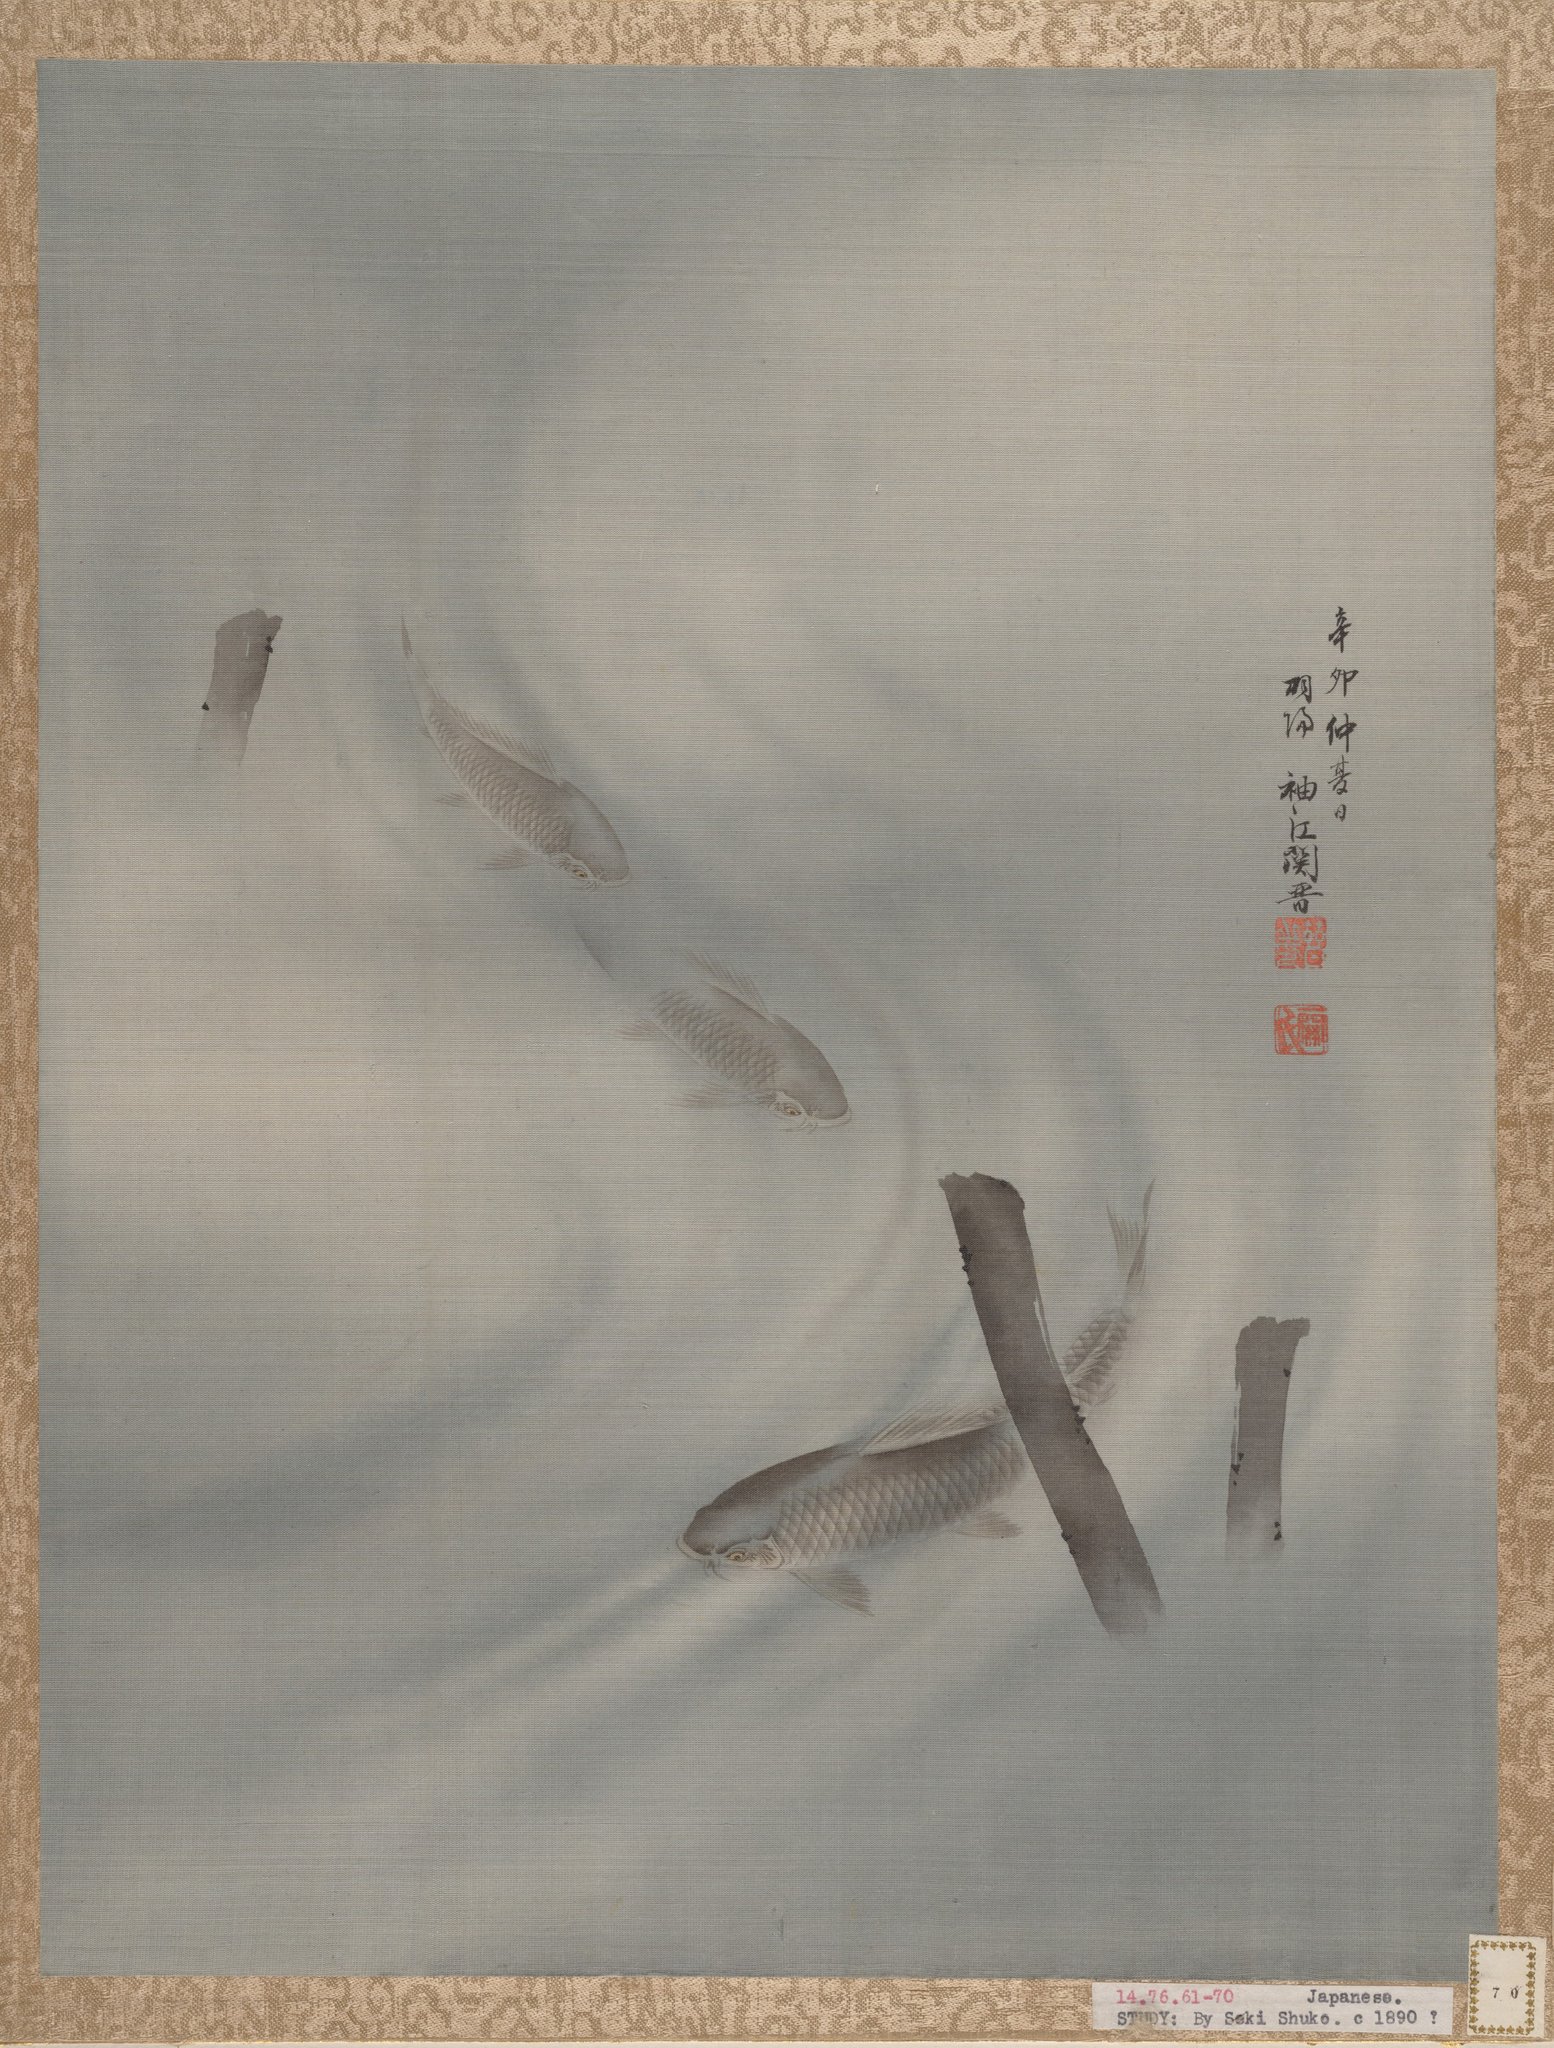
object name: album leaf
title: Fishes Swimming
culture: japanese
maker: seki shūkō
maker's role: artist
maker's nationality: japanese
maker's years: 1858-1915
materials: ink, silk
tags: fish